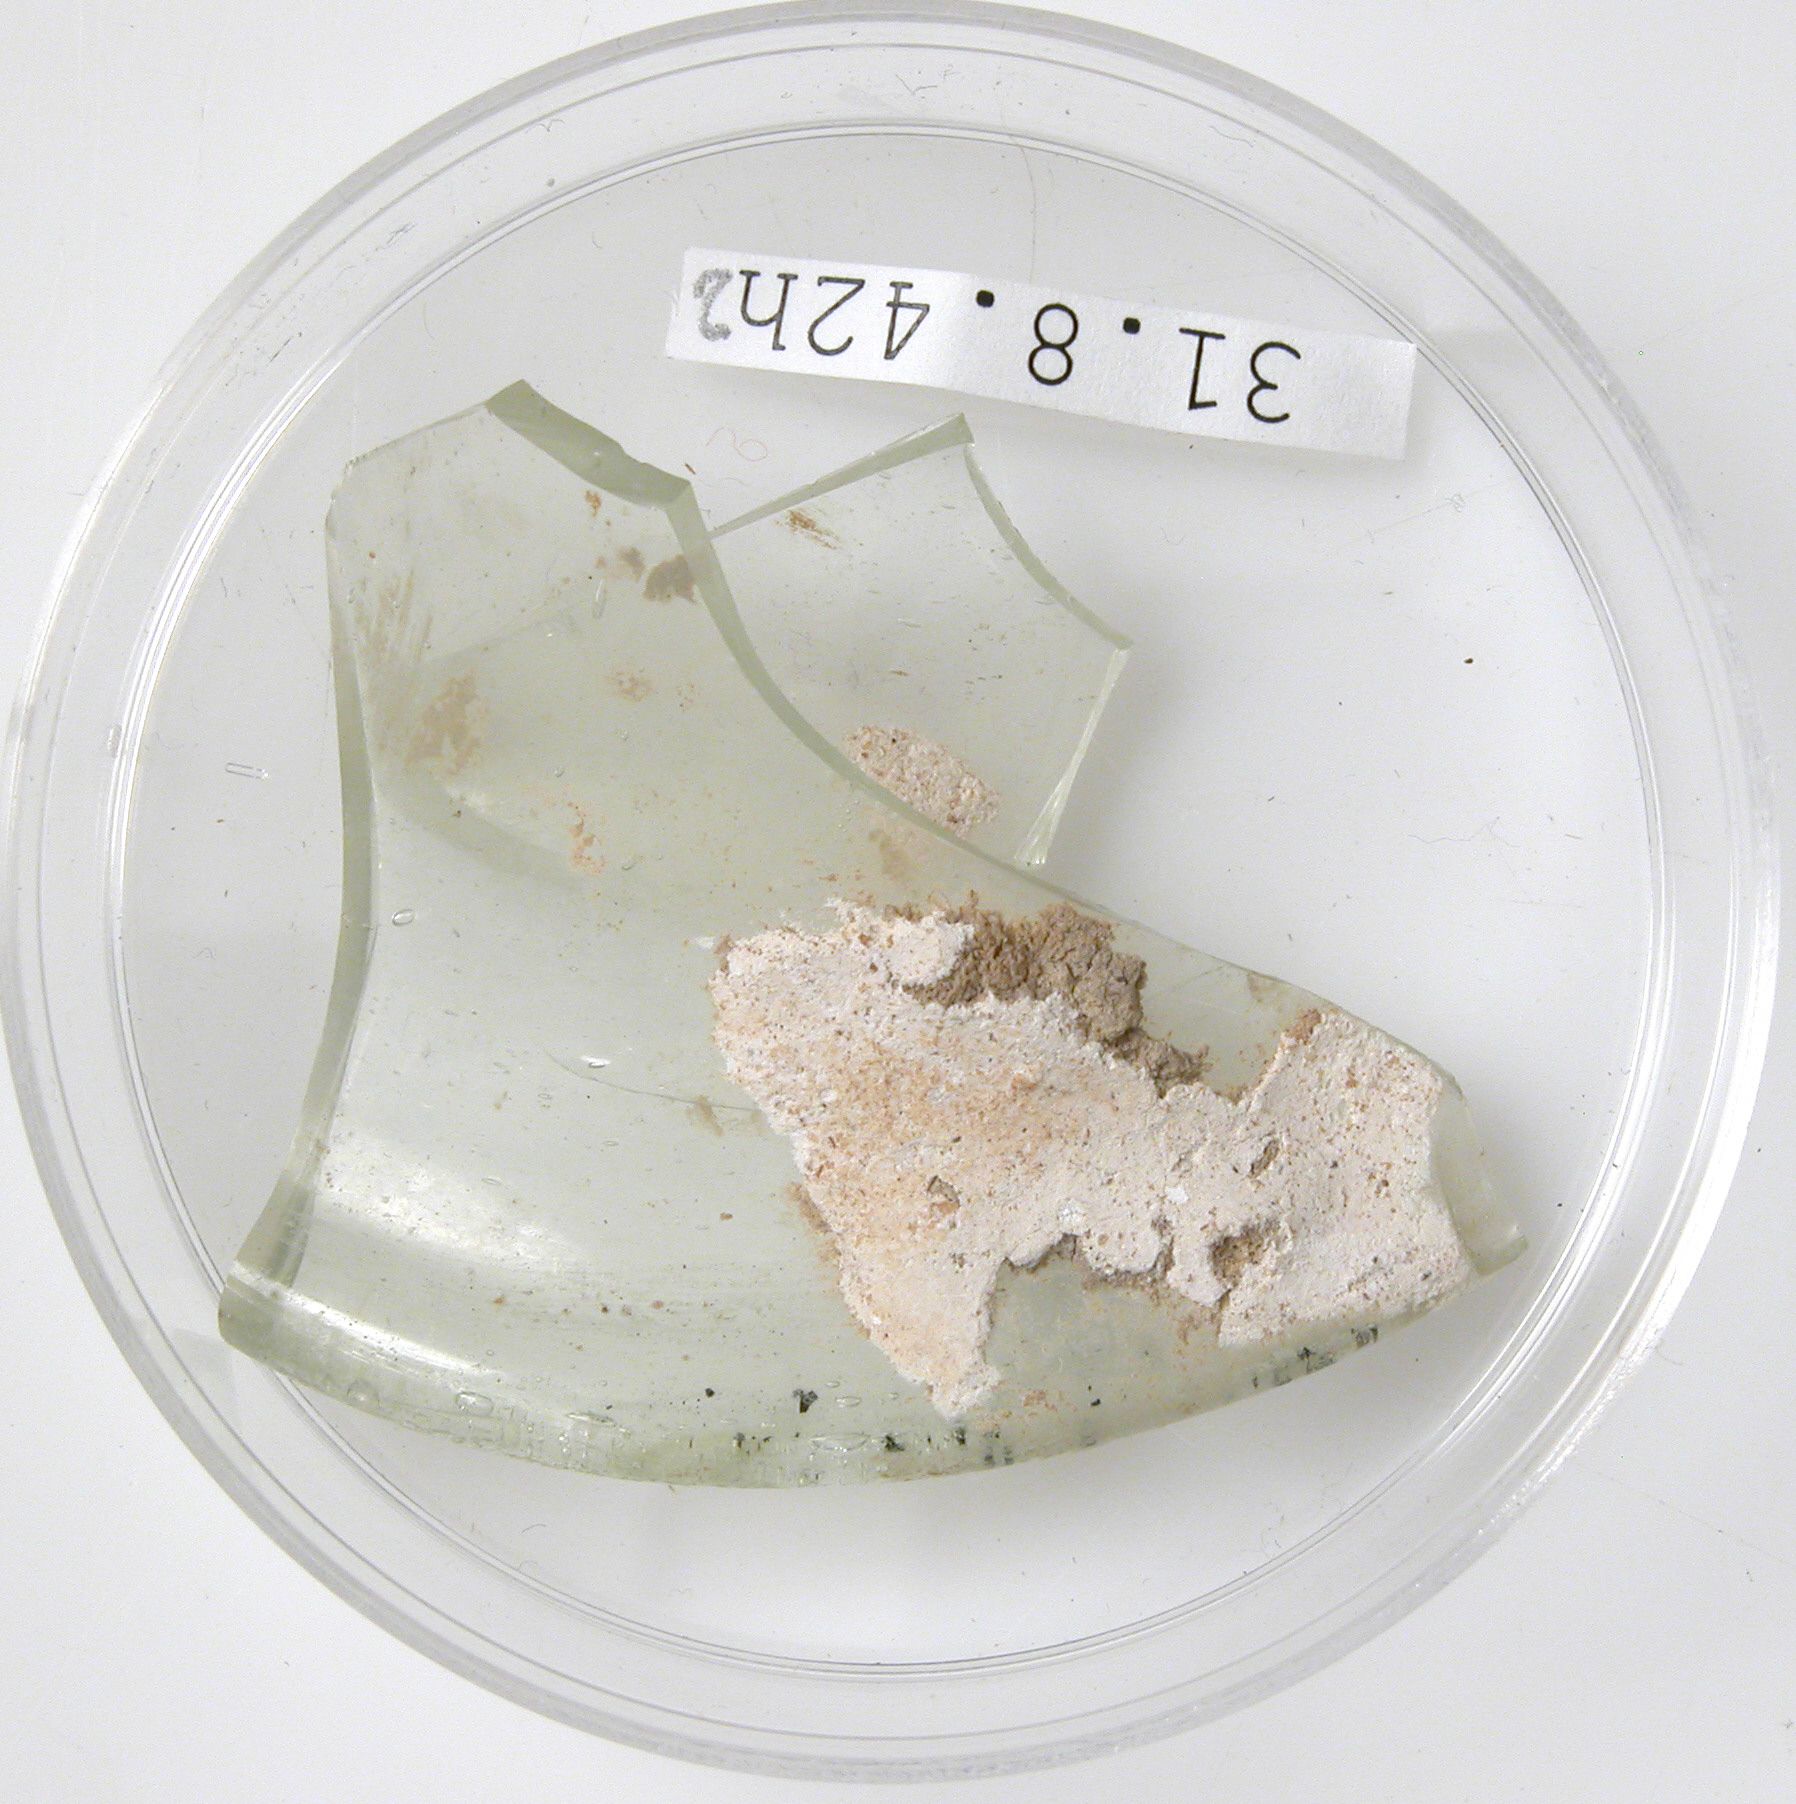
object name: fragment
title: Glass Fragments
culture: coptic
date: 301-400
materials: glass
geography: egypt